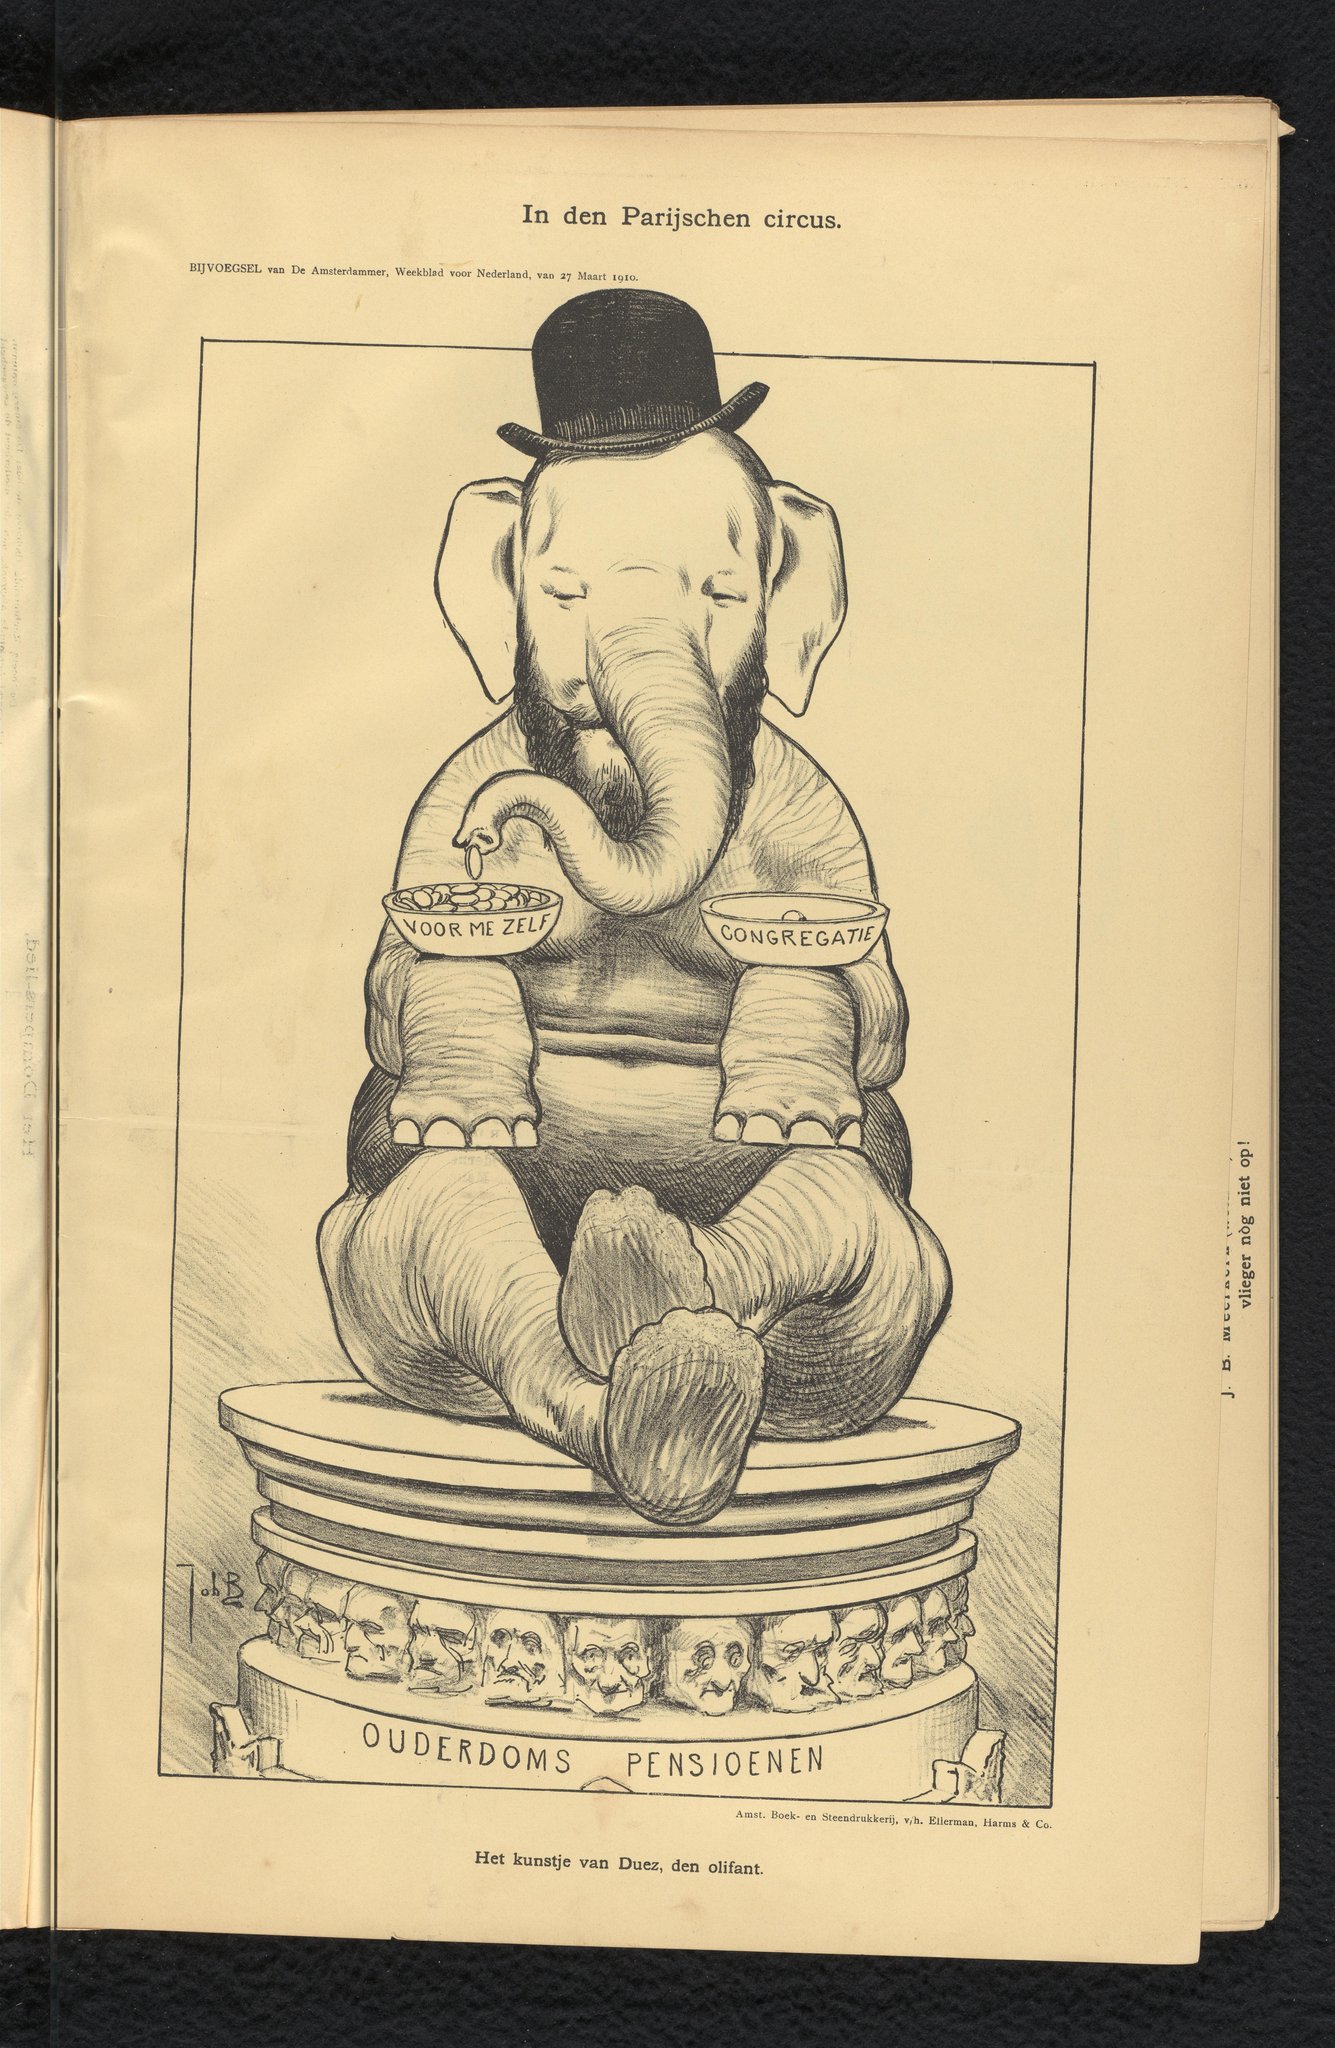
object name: cartoon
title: In den Parijschen circus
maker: johan braakensiek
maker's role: draughtsman, print maker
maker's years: 1858-1940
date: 1910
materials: paper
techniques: lithograph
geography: netherlands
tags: elephants (circus performance), automaton, trunked animals: elephant, political caricatures and satires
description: De Franse curator en fraudeur M. Duez die de hem toevertrouwde fondsen van kerkelijke organisaties verduisterde voorgesteld als een zittende olifant, een circusattractie. Hij werd in maart 1910 gearresteerd, de zogenaamde 'affaire Duez'.